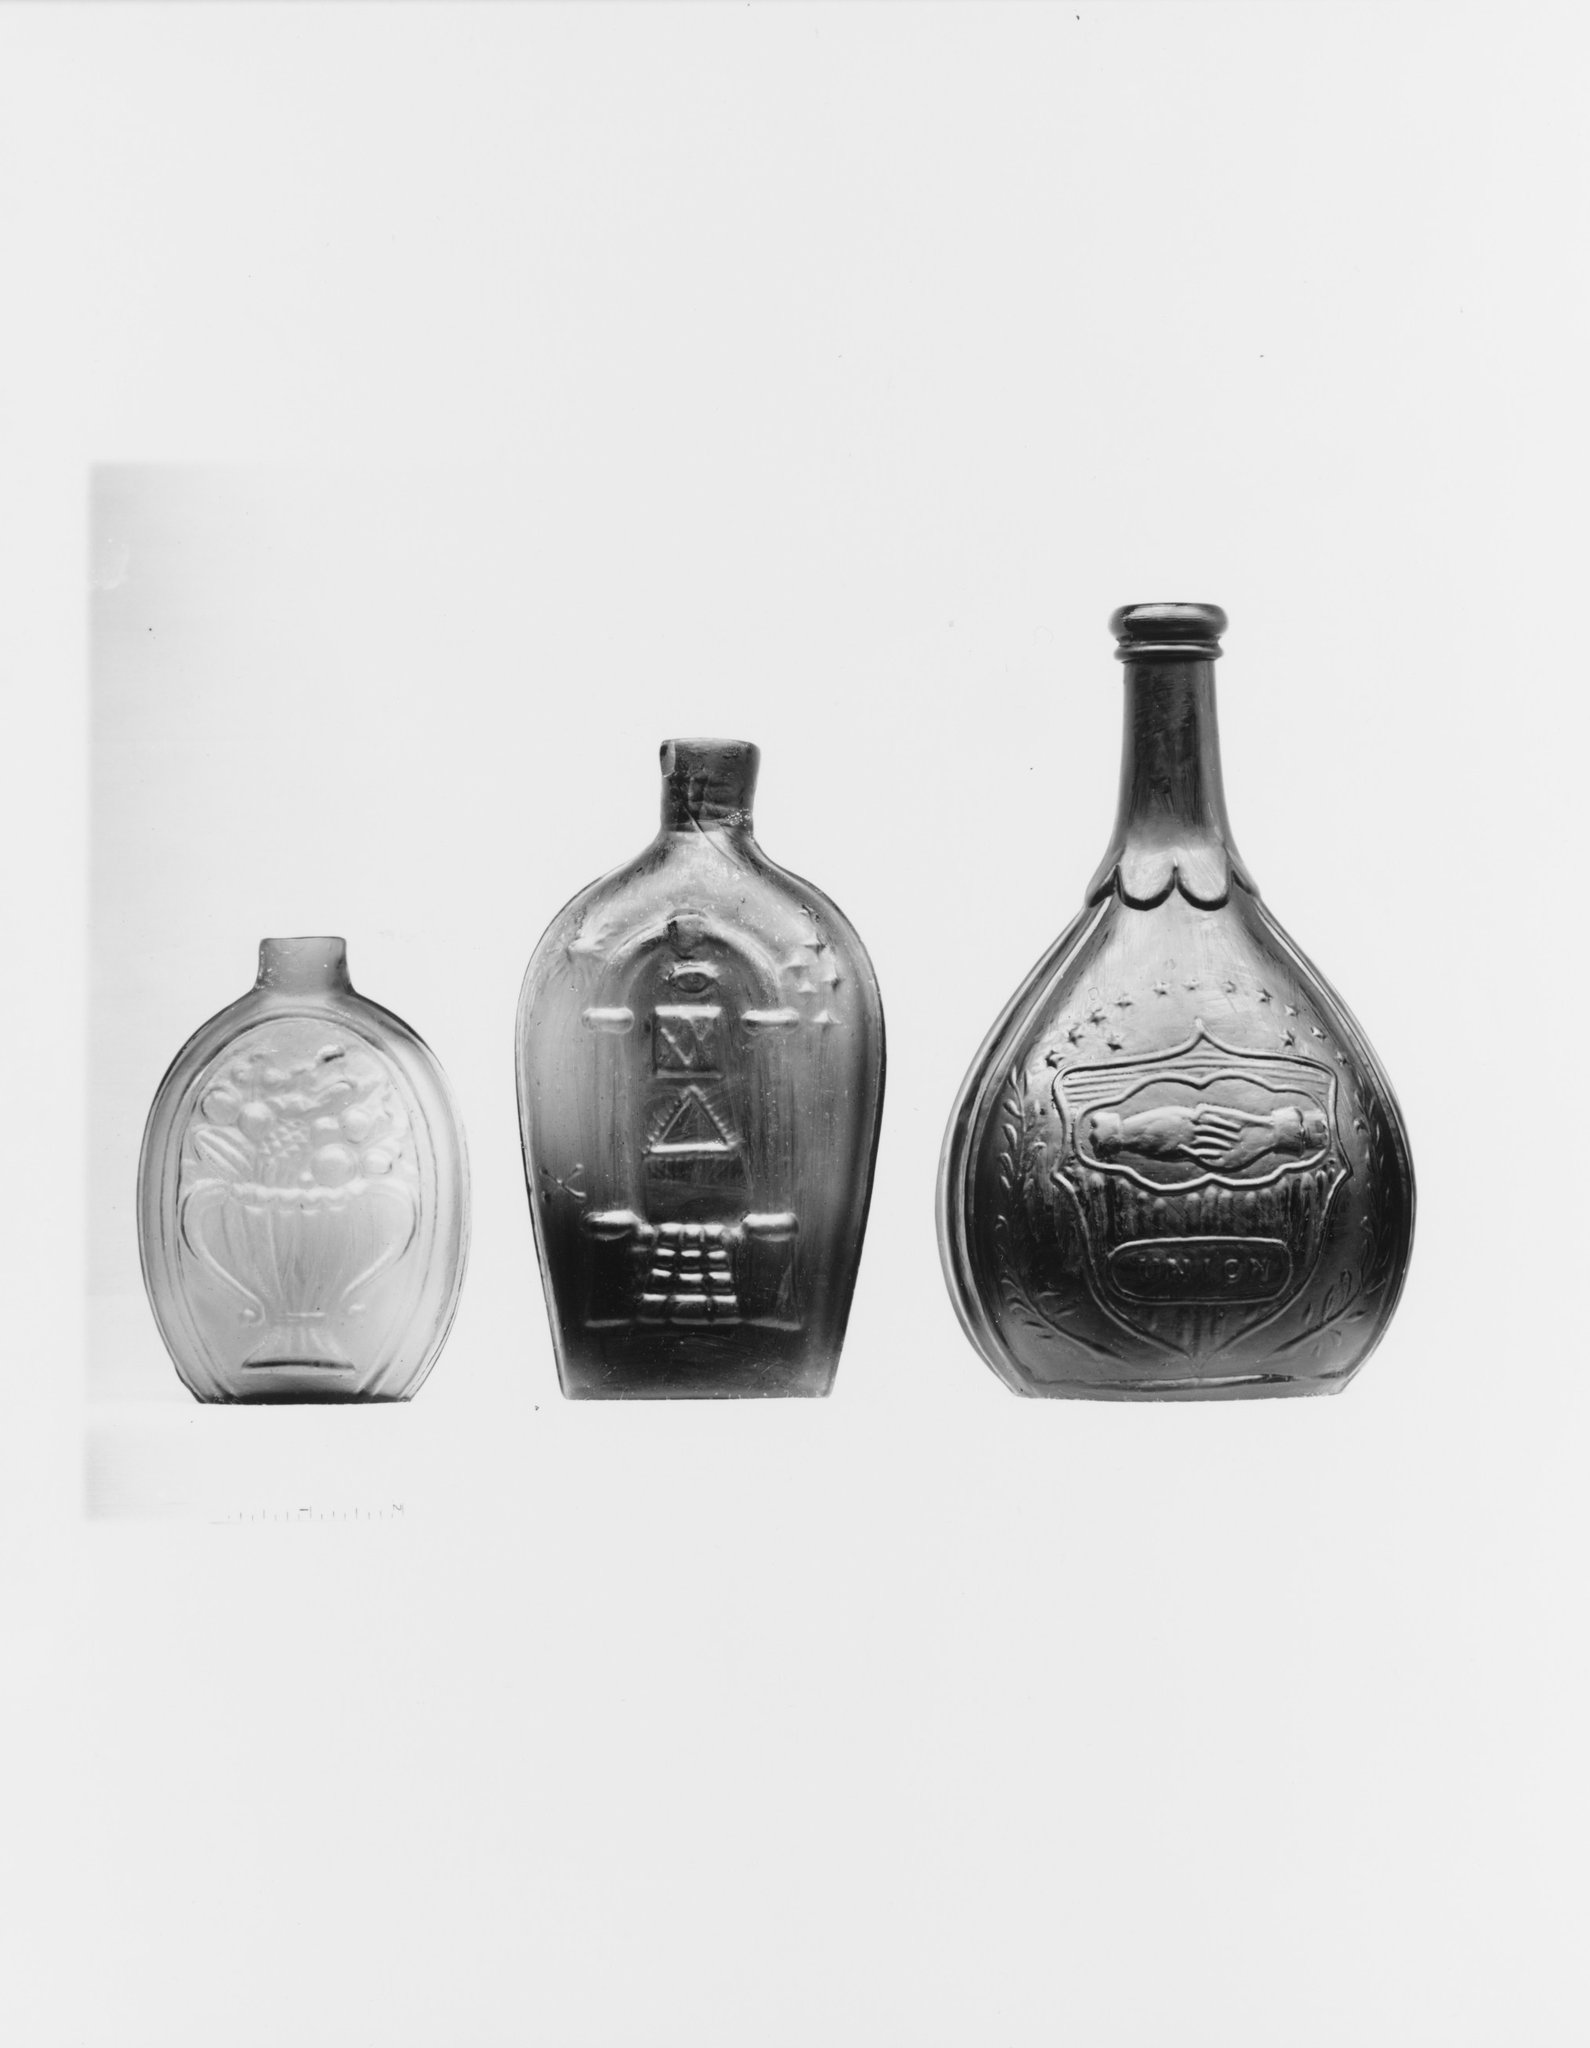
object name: bottle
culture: american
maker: a. r. samuels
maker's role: maker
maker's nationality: american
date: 1860-1870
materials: amber, glass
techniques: glassblowing, molding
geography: united states